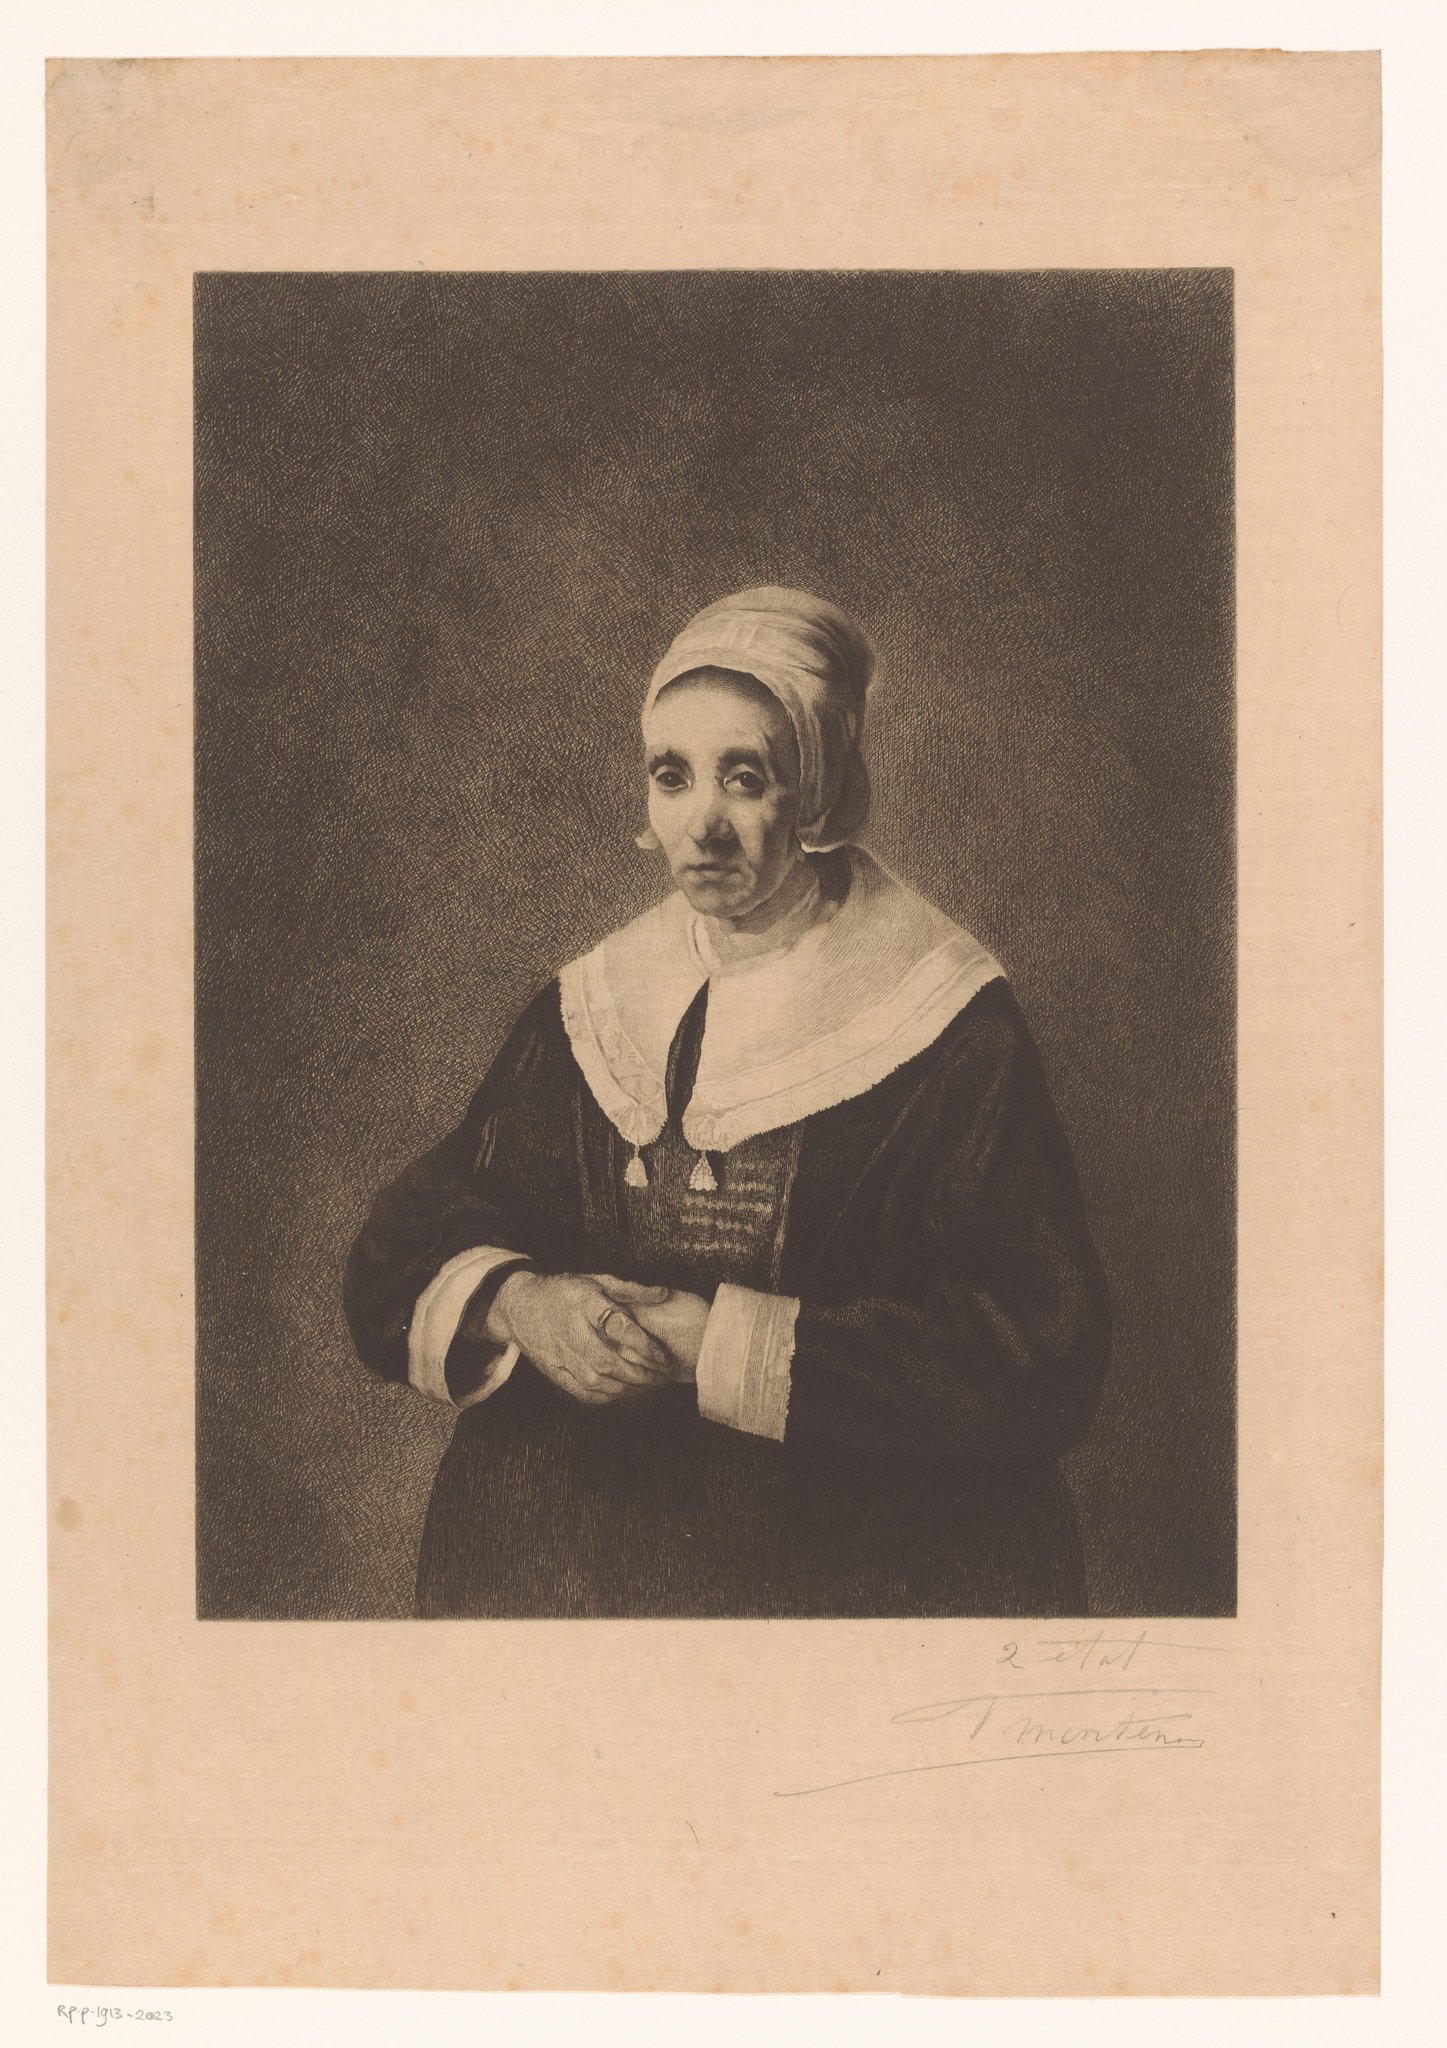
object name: print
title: Portret van een onbekende vrouw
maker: georges montenez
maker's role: print maker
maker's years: 1873-1930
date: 1883-1913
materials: paper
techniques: etching, intaglio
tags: adult woman, historical persons, head-gear: cap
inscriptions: inscription: ‘2 état’, collector's mark: Lugt 2228